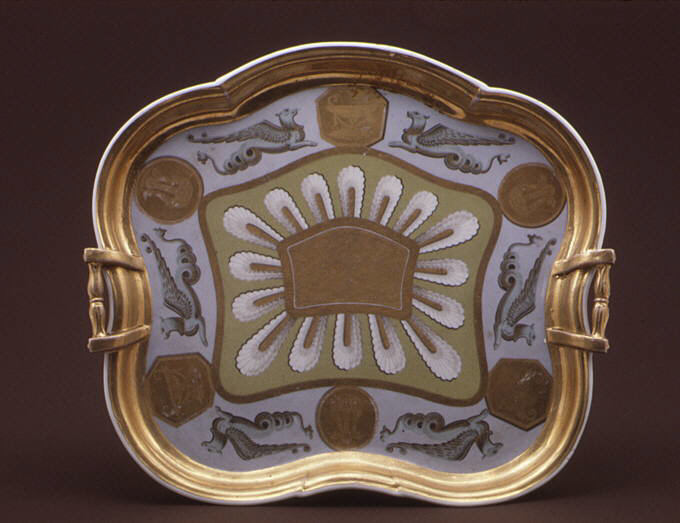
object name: tray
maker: popov manufactory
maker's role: manufactory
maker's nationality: russian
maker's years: 1811-1875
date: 1815-1820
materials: hard paste porcelain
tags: mythical creatures